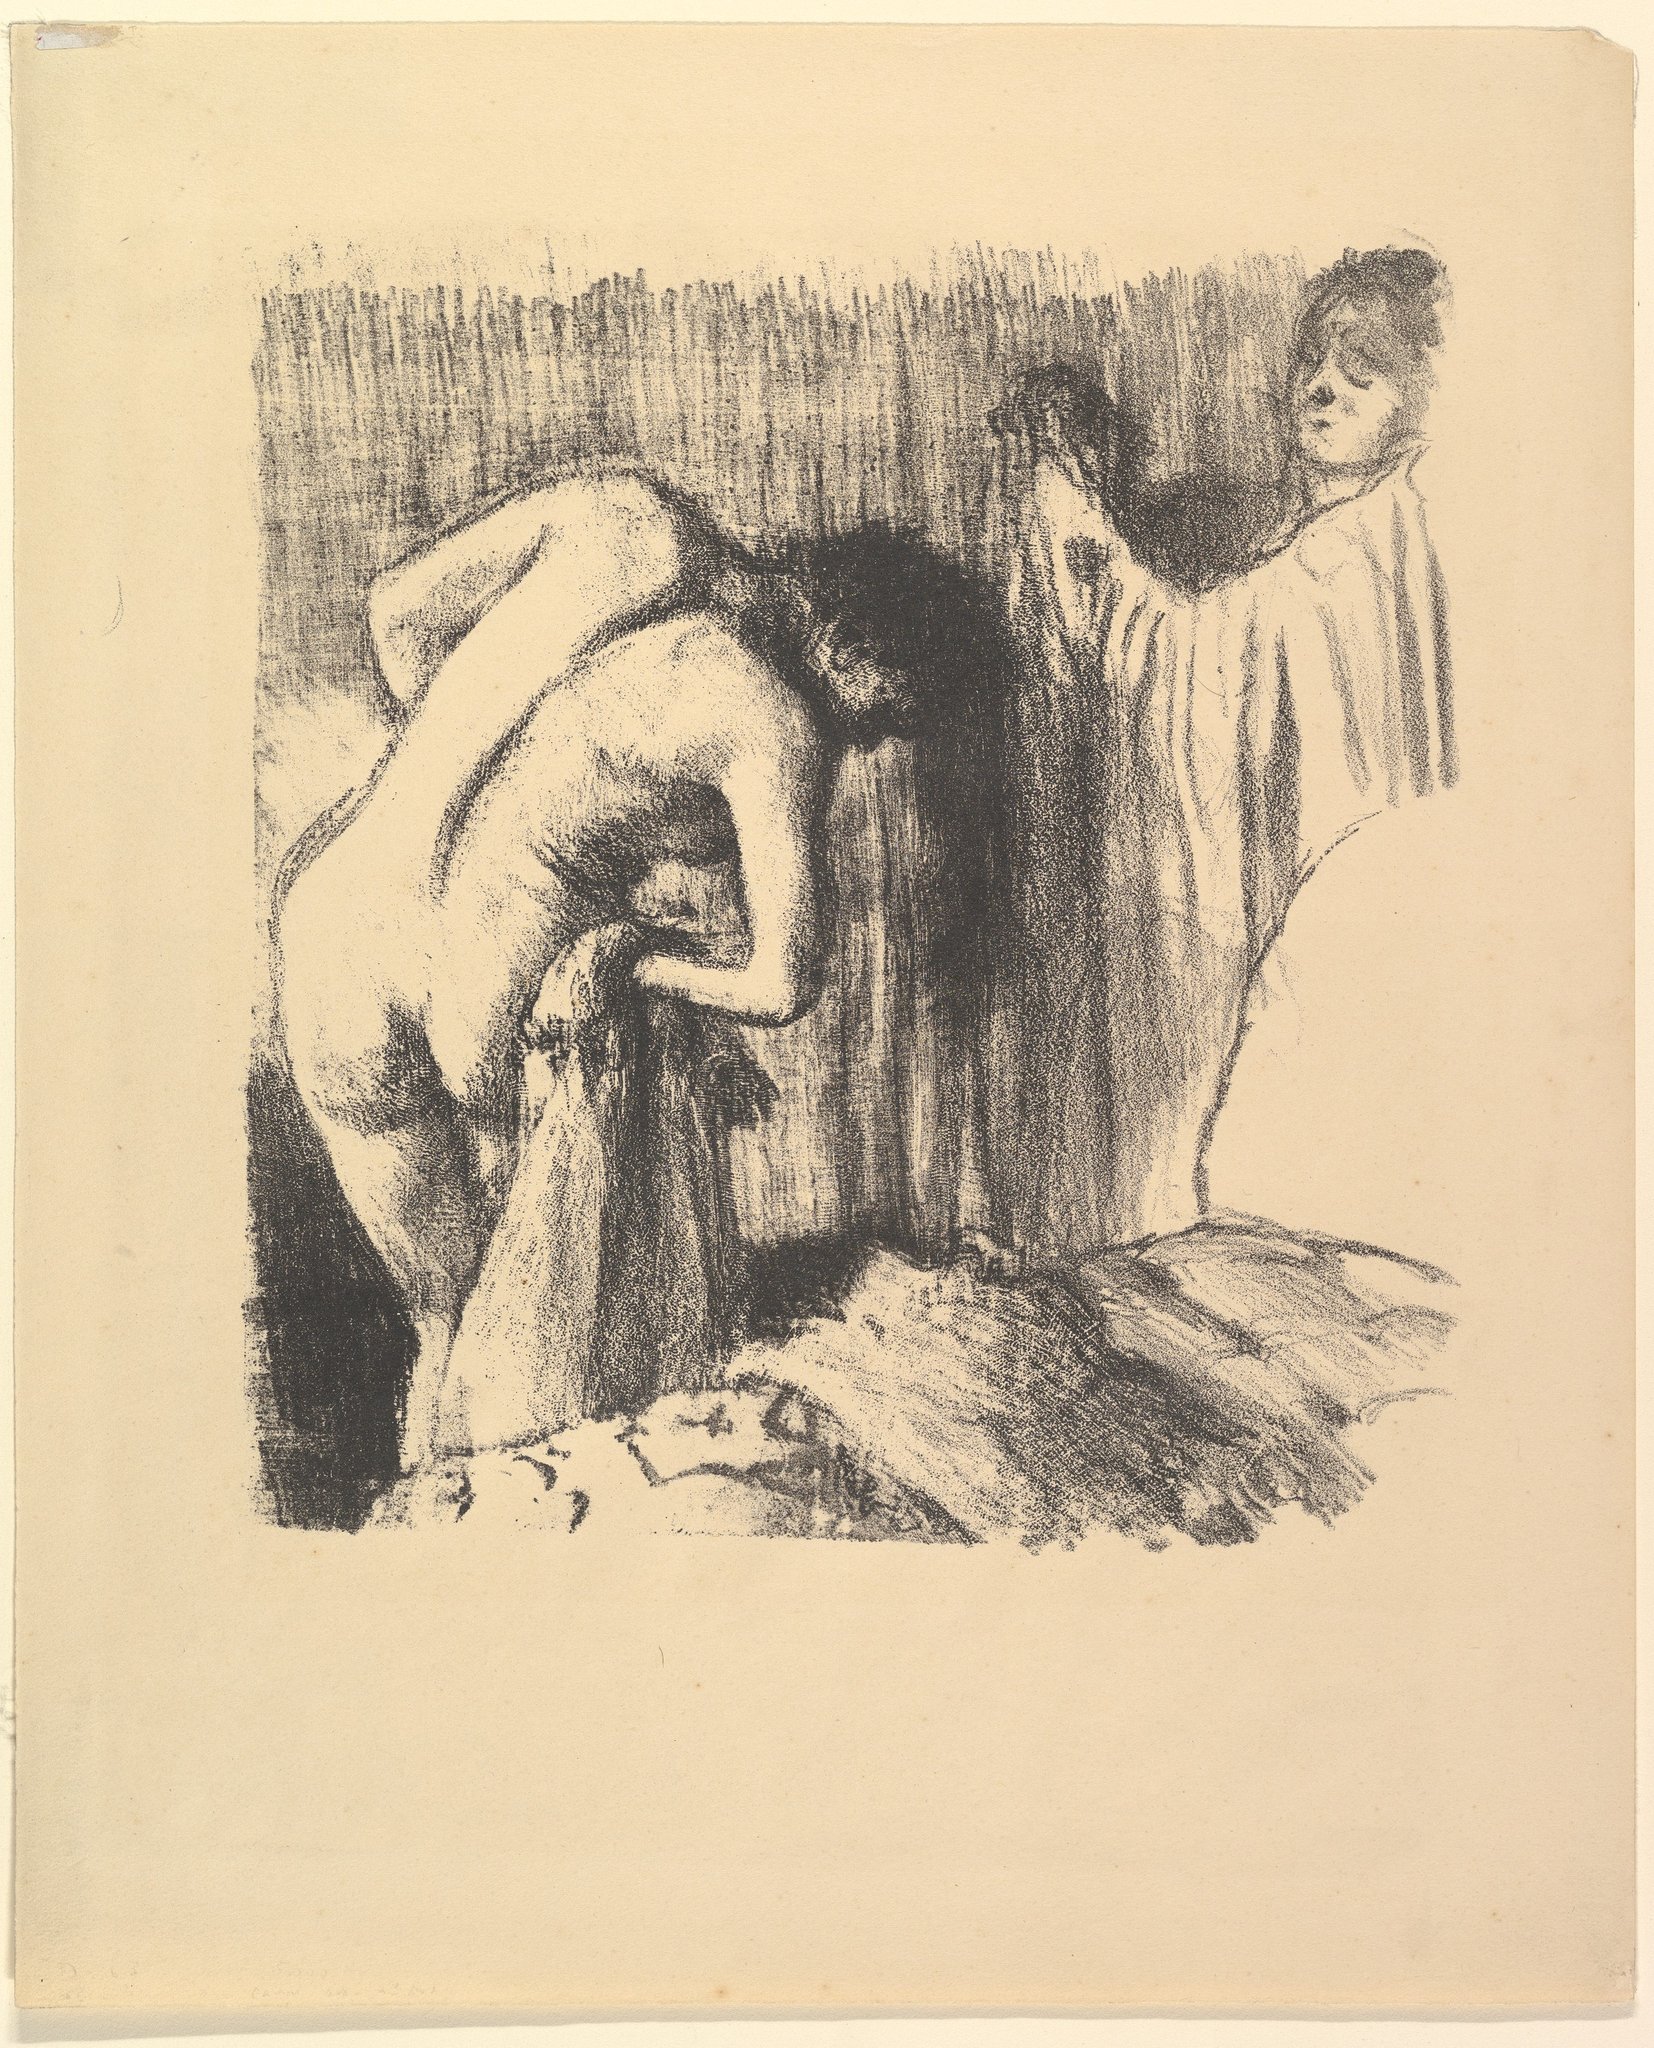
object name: print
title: After the Bath III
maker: edgar degas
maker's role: artist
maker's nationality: french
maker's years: 1834-1917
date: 1891-1892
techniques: lithograph, transfer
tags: female nudes